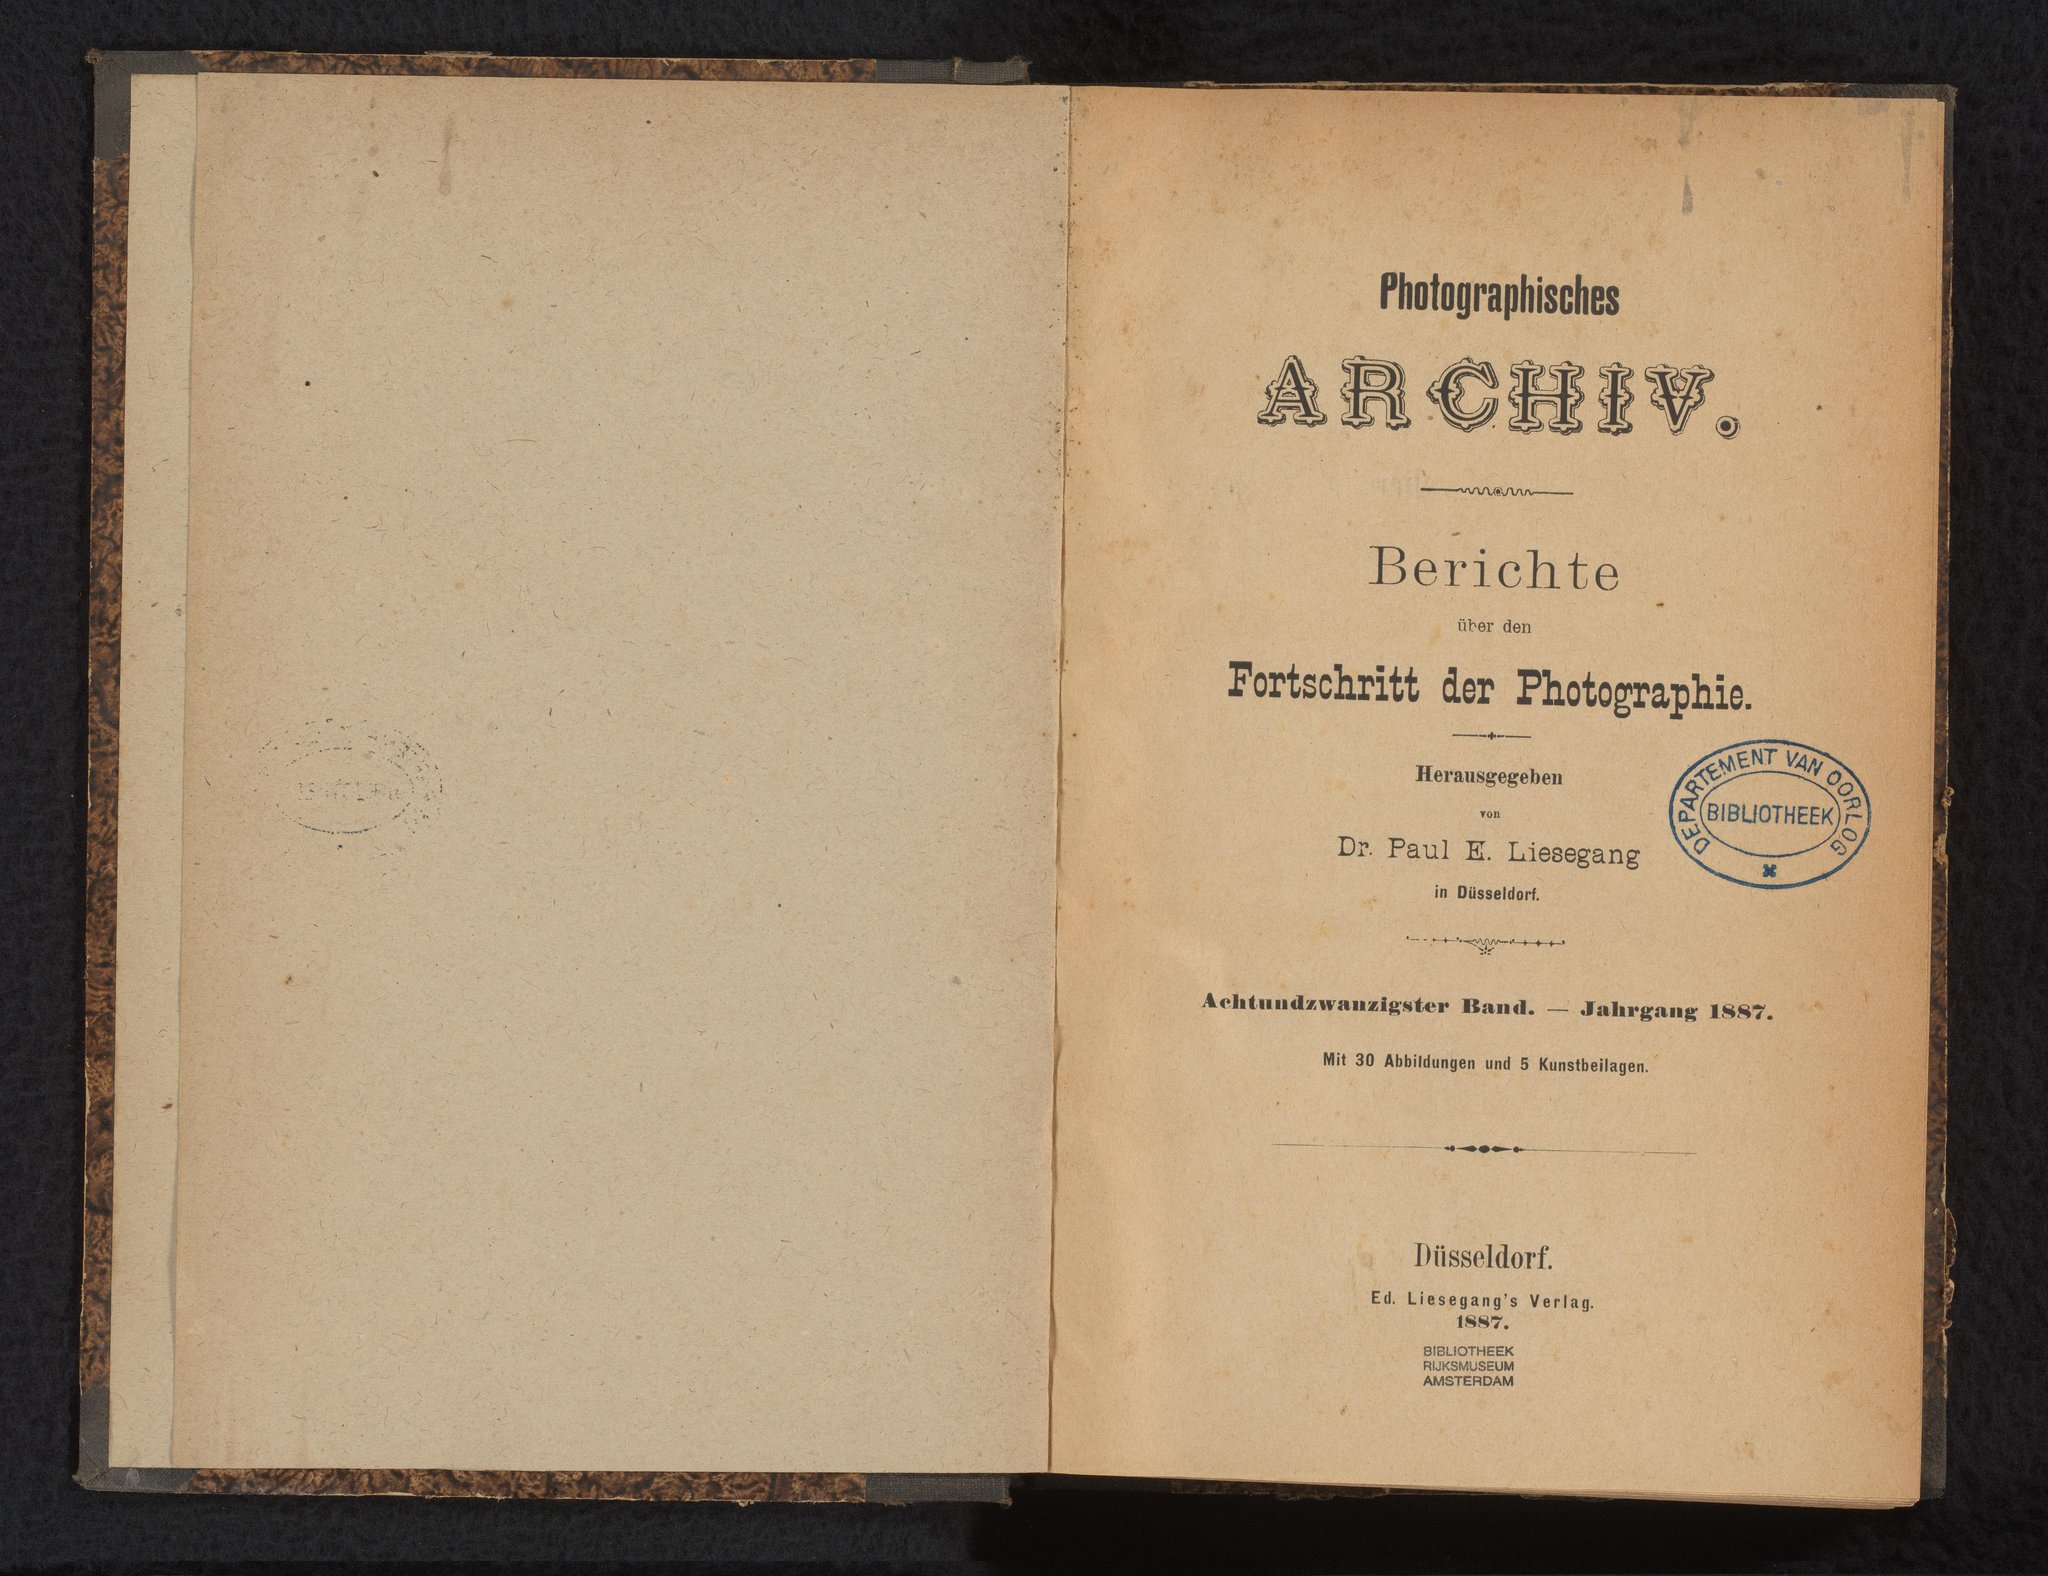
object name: book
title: Photographisches Archiv. Achtundzwanzigster Band - Jahrgang 1887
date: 1887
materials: cardboard, linen, paper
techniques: photograph, engraving, letterpress printing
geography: dusseldorf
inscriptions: stamp: ‘Departement/ Bibliotheek/ van oorlog.’, stamp: ‘Departement van oorlog/ Bibliotheek’